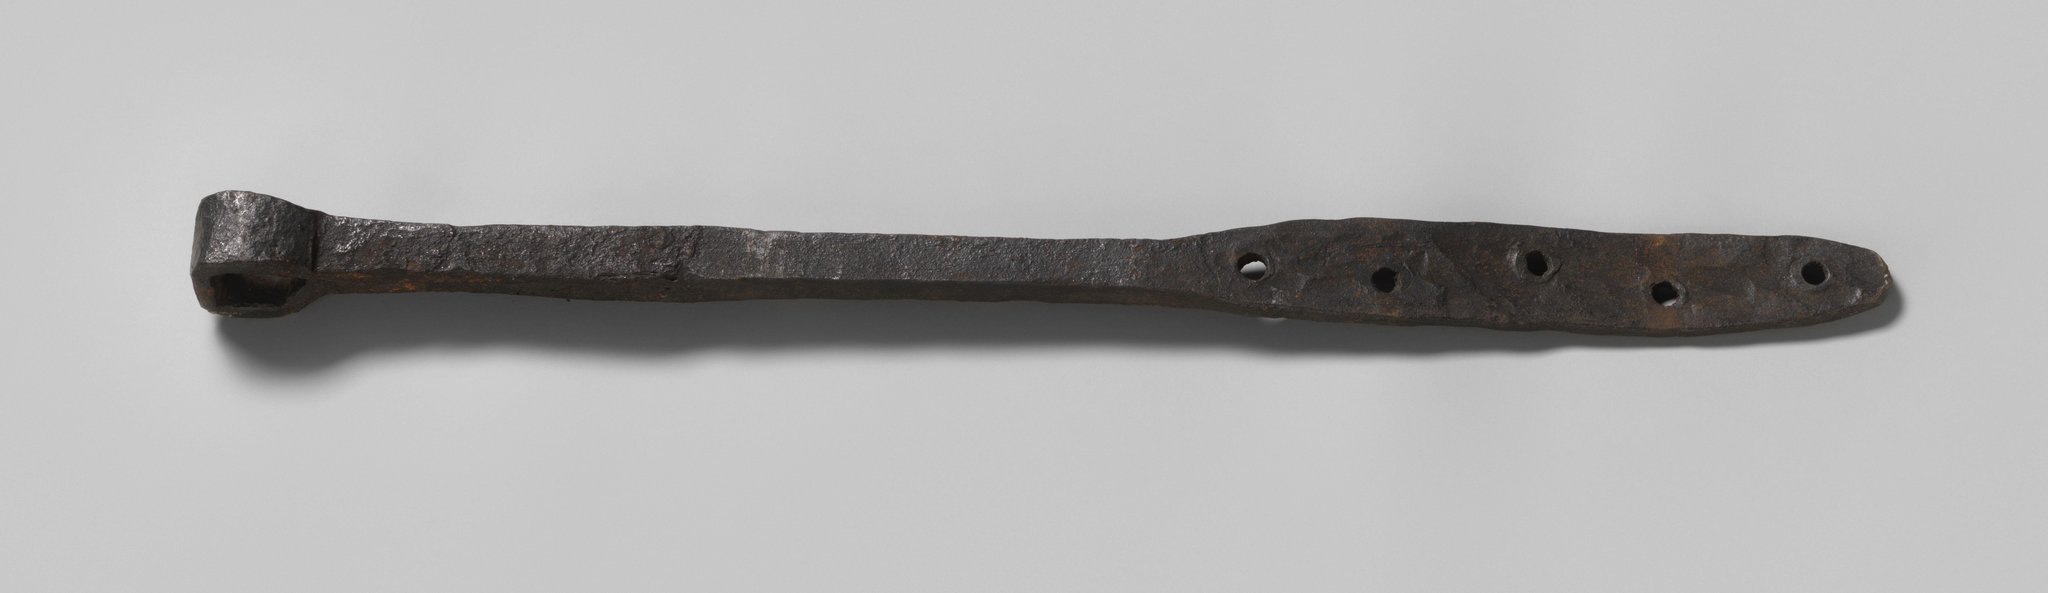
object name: anchor tie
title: Veer met schieter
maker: Anonymous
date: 1500-1600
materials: iron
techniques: forging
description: Veer en schieter behorend bij een muuranker in gotische stijl.